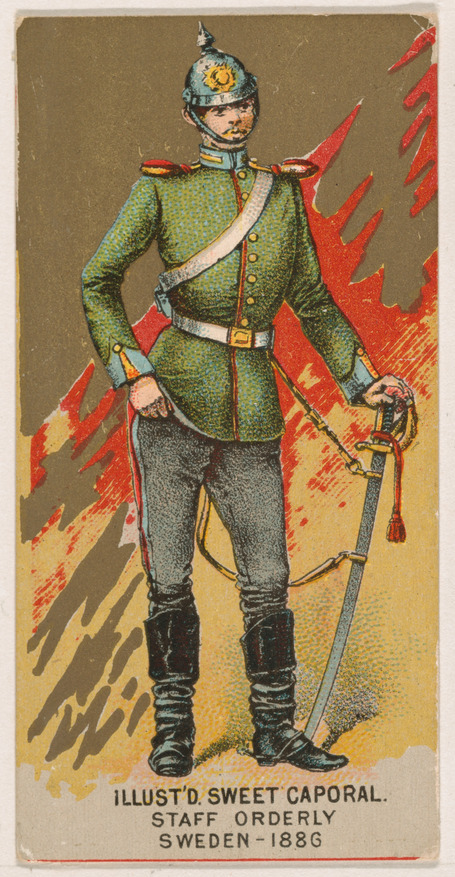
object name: print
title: Staff Orderly, Sweden, 1886, from the Military Series (N224) issued by Kinney Tobacco Company to promote Sweet Caporal Cigarettes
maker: kinney brothers tobacco company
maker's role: publisher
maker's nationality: american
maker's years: 1869-2011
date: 1888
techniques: color lithograph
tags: military,swords,men